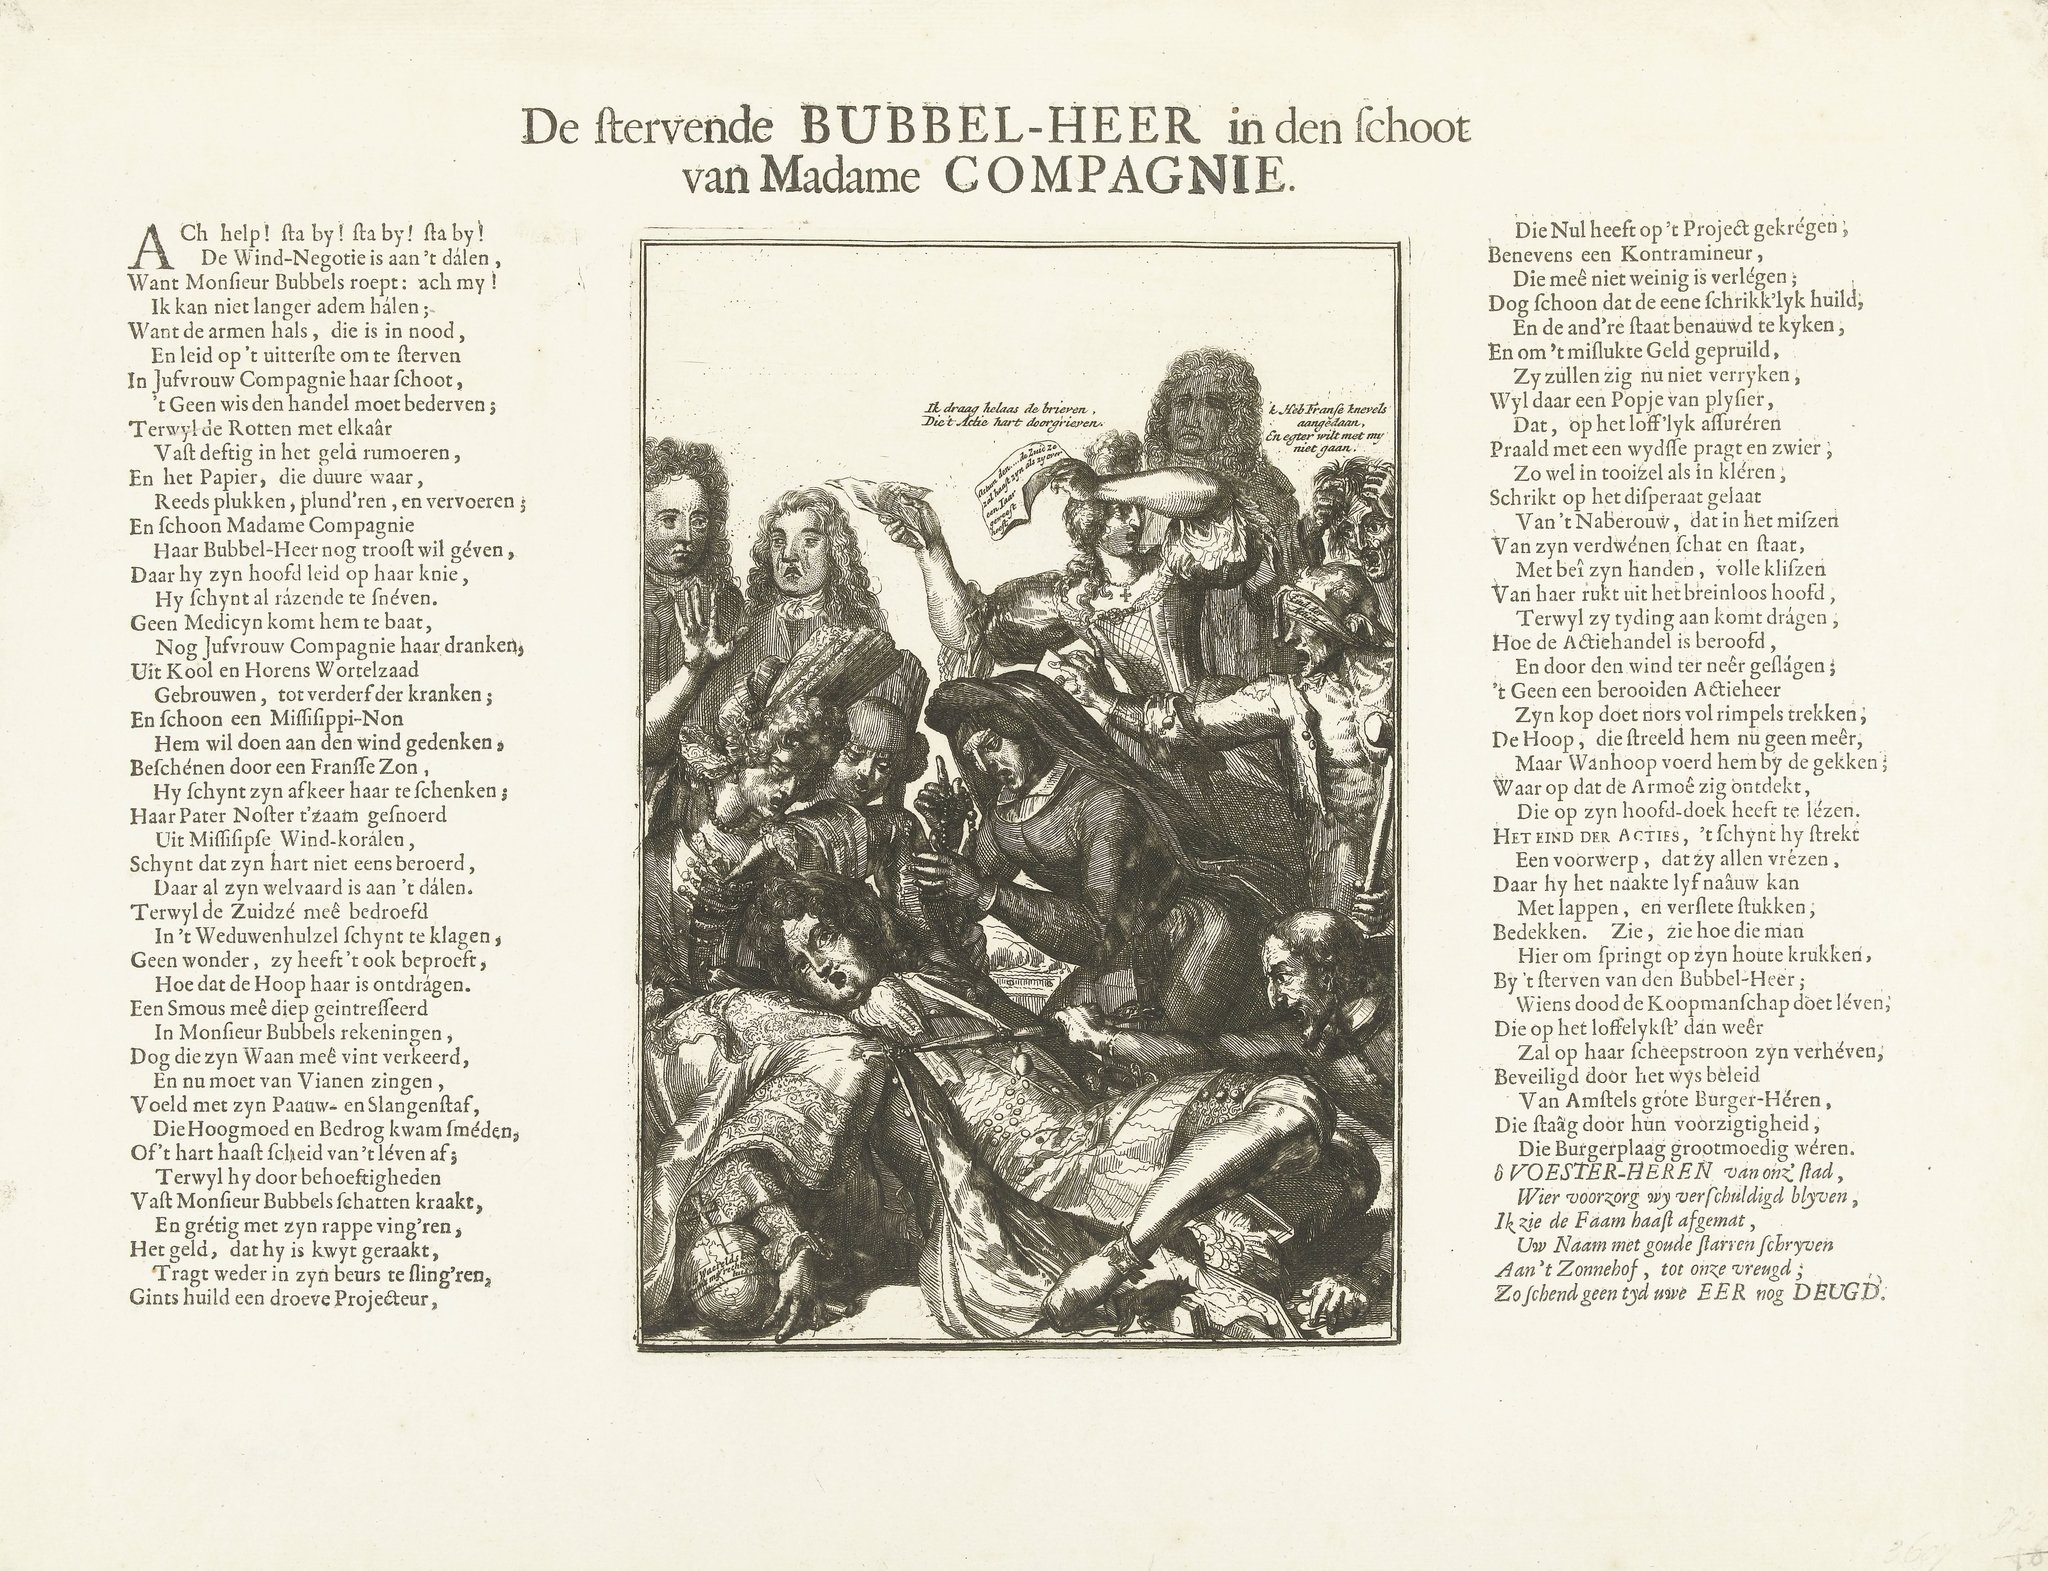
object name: cartoon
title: Het Groote Tafereel der Dwaasheid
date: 1706-1707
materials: paper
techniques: etching, letterpress printing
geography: southern netherlands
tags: patient, sick person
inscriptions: collector's mark: Lugt 2228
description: De stervende windhandelaar of bubbelheer John Law achterover liggend in de schoot van Madame Compagnie wordt getroost door een non en een biechtvader. Met een vers aan weerszijden van de plaat. Prent 72 in de serie Het Groote Tafereel der Dwaasheid met spotprenten op de Windhandel of Actiehandel van 1720.